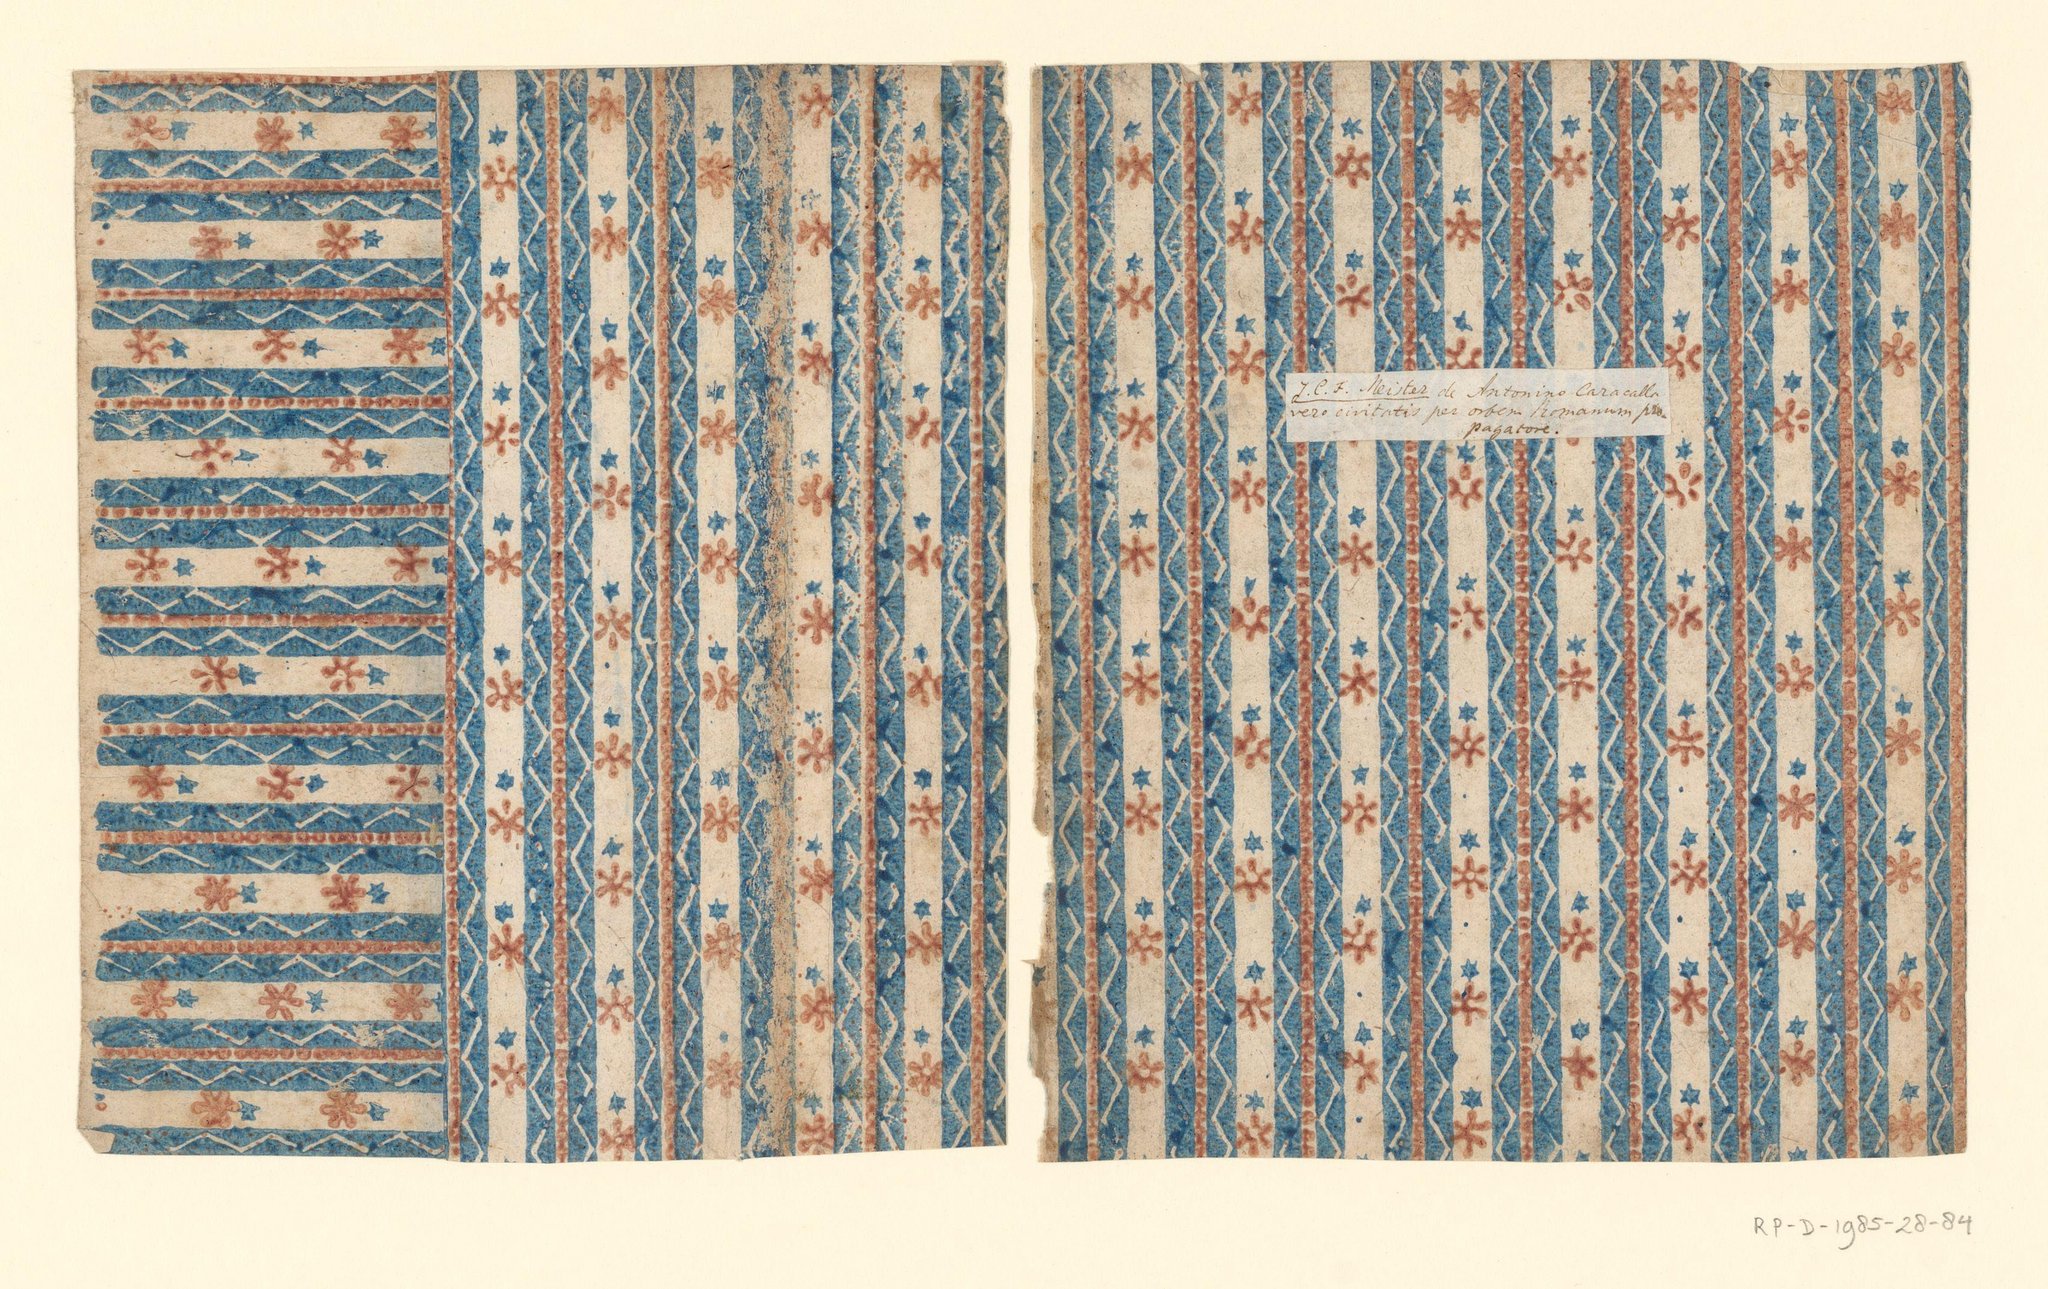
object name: printed paper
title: Twee bladen met banenpatroon in sterren en zigzaglijnen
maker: Anonymous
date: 1750-1900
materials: paper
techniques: printing block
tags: ornament ~ geometric motifs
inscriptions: collector's mark: Lugt 2228, collector's mark: Lugt 2760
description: Twee bladen met verticaal banenpatroon in sterren en zigzaglijnen. Met etiket met opschrift: 'J.C.F. Neister ... pagatore.' Twee losse helften van een omslag.